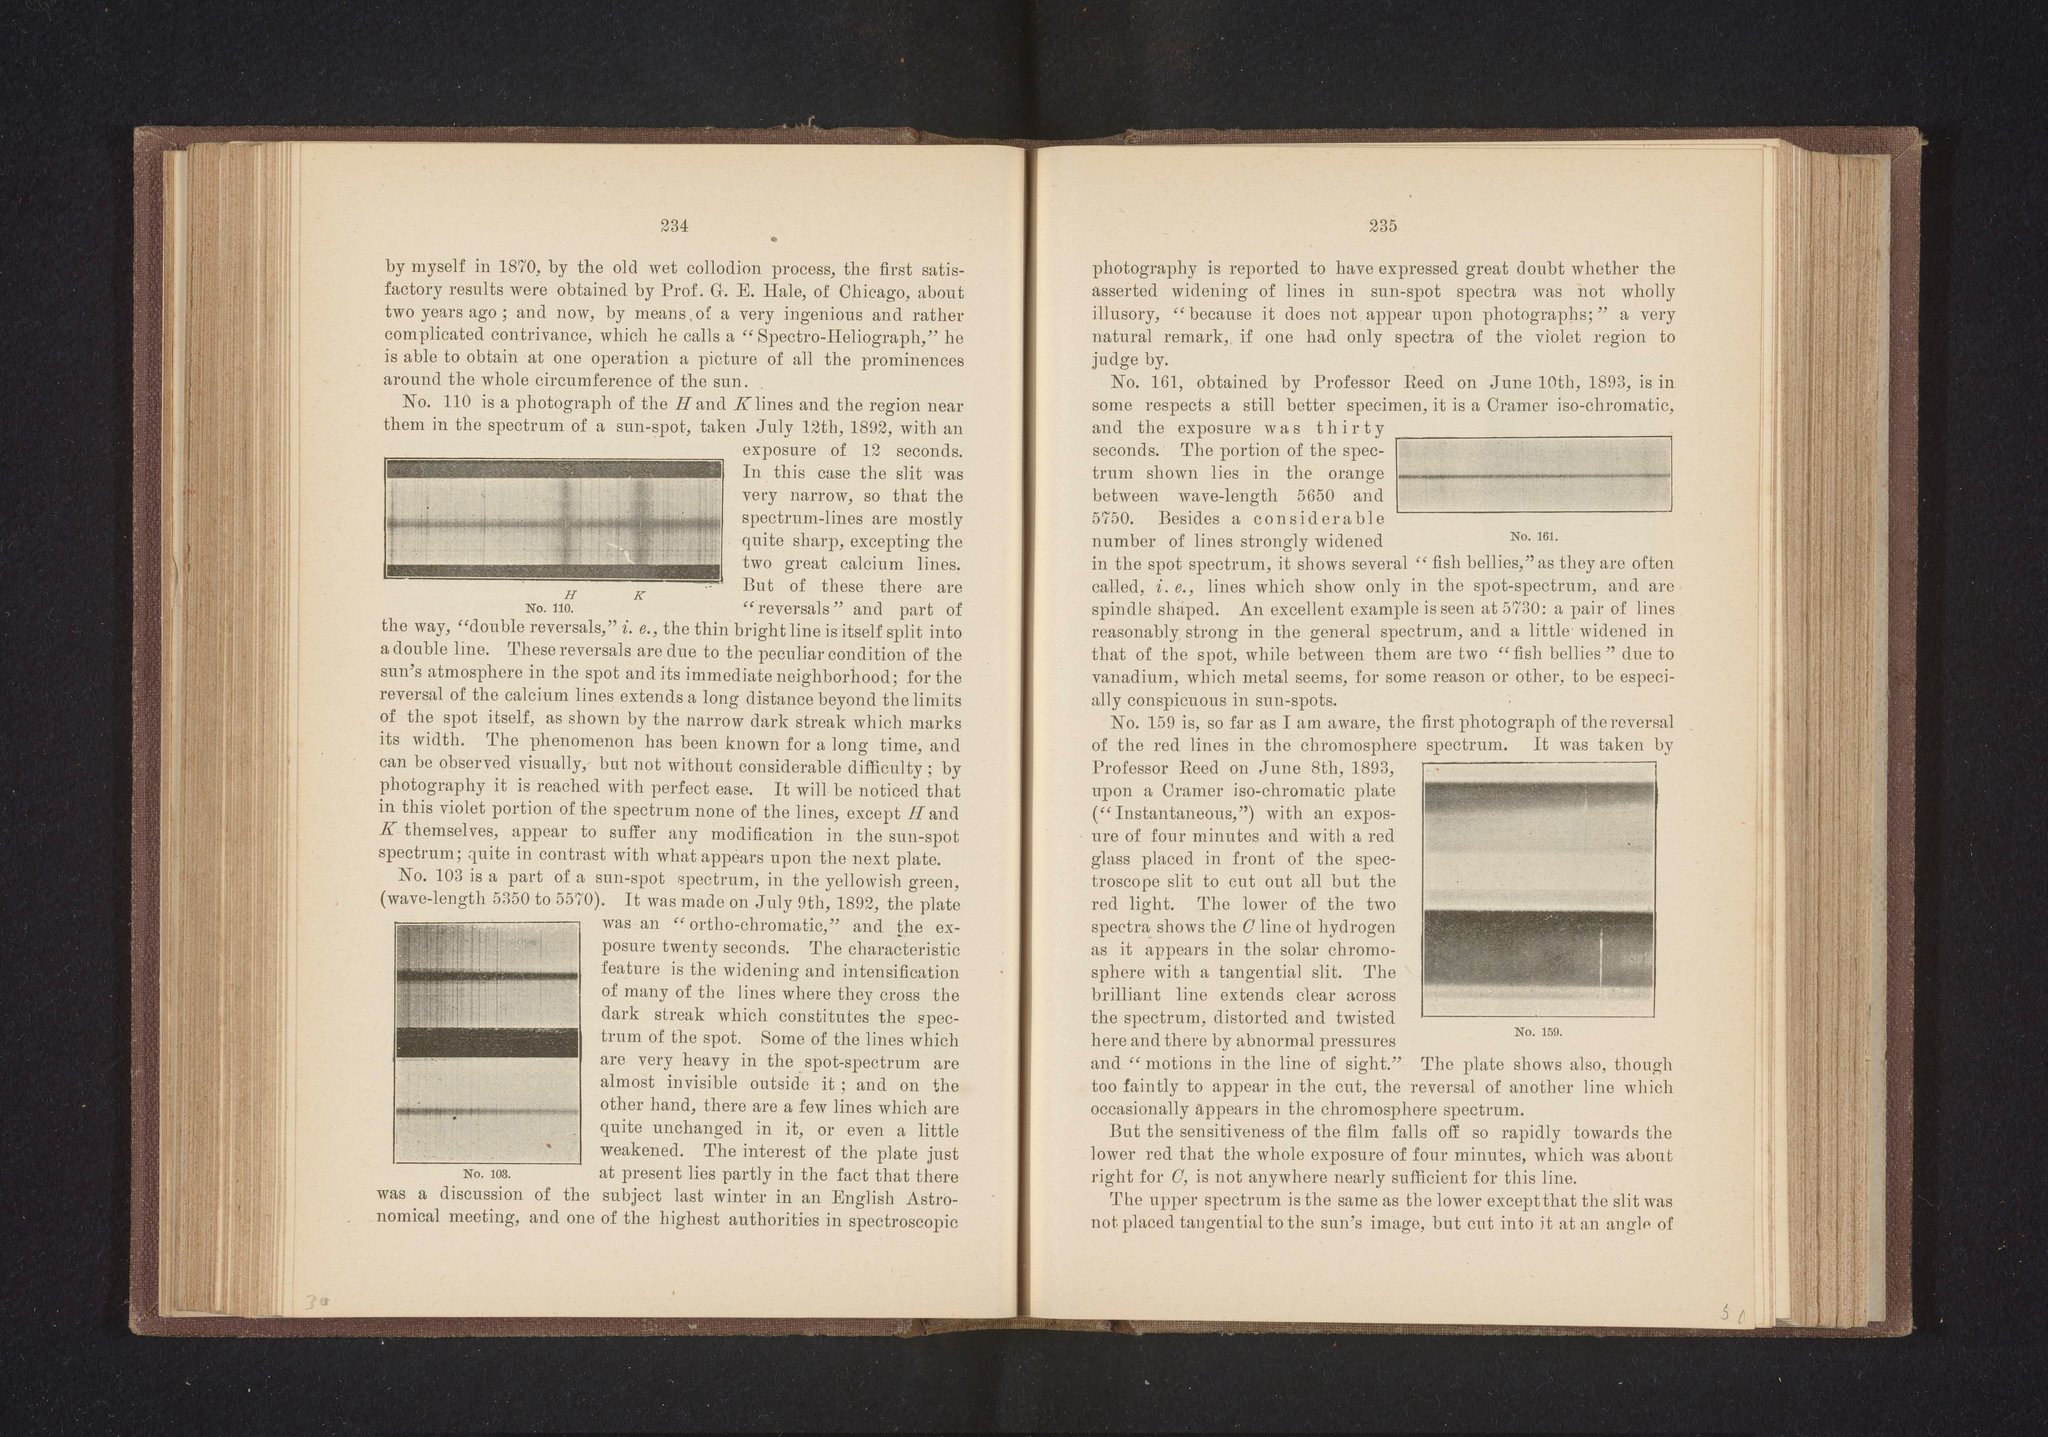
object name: page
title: Twee gezichten op zonnevlekken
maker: Anonymous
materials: paper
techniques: autotype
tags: sun-spots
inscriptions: number: ‘No. 110. No. 108.’